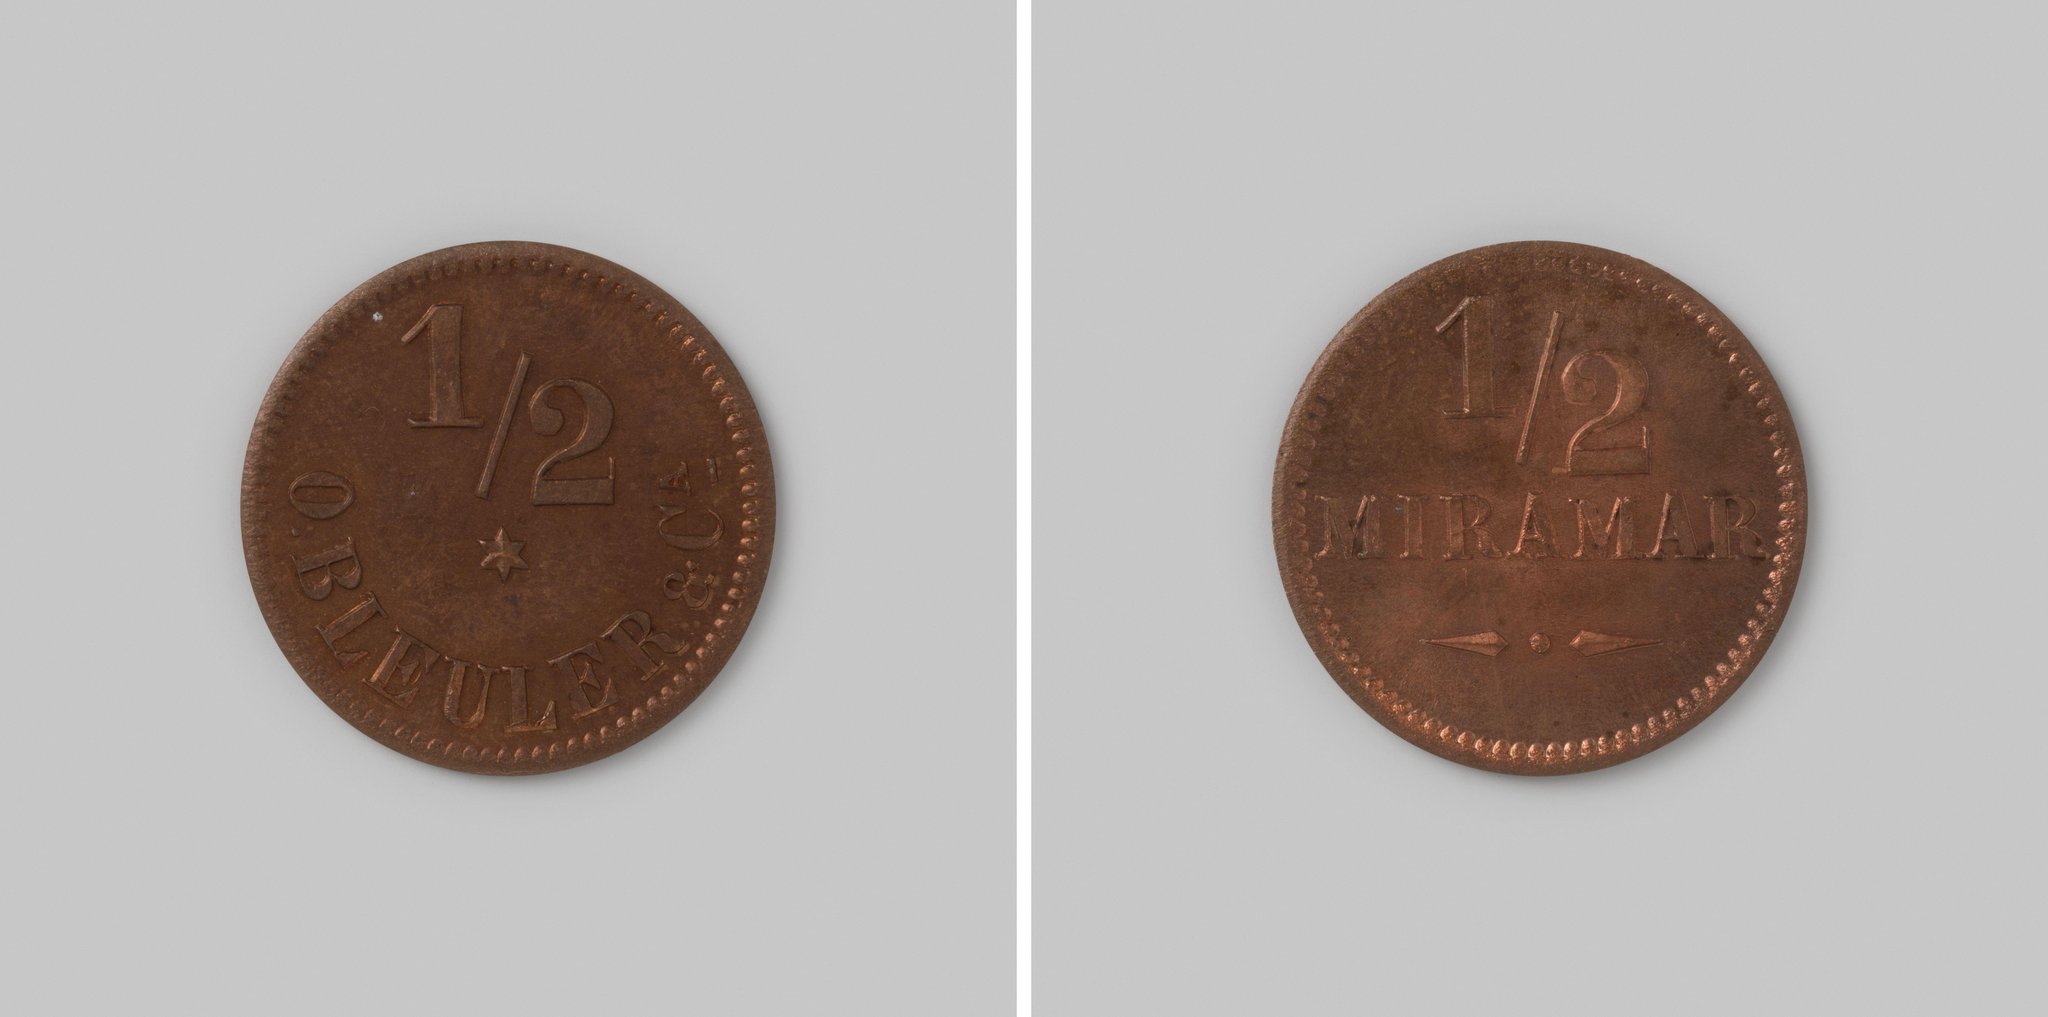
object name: coin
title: Particuliere munt van ½ reaal op naam van O. Bleuler & Co uit Miramar in Guatemala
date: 1800-1900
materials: copper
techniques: striking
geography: guatemala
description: Koperen particuliere munt. Voorzijde: waarde-aanduiding: ½.. In omschrift firma-aanduiding. Keerzijde: waarde-aanduiding: ½.. In omschrift plaats-aanduiding. Gladde rand.